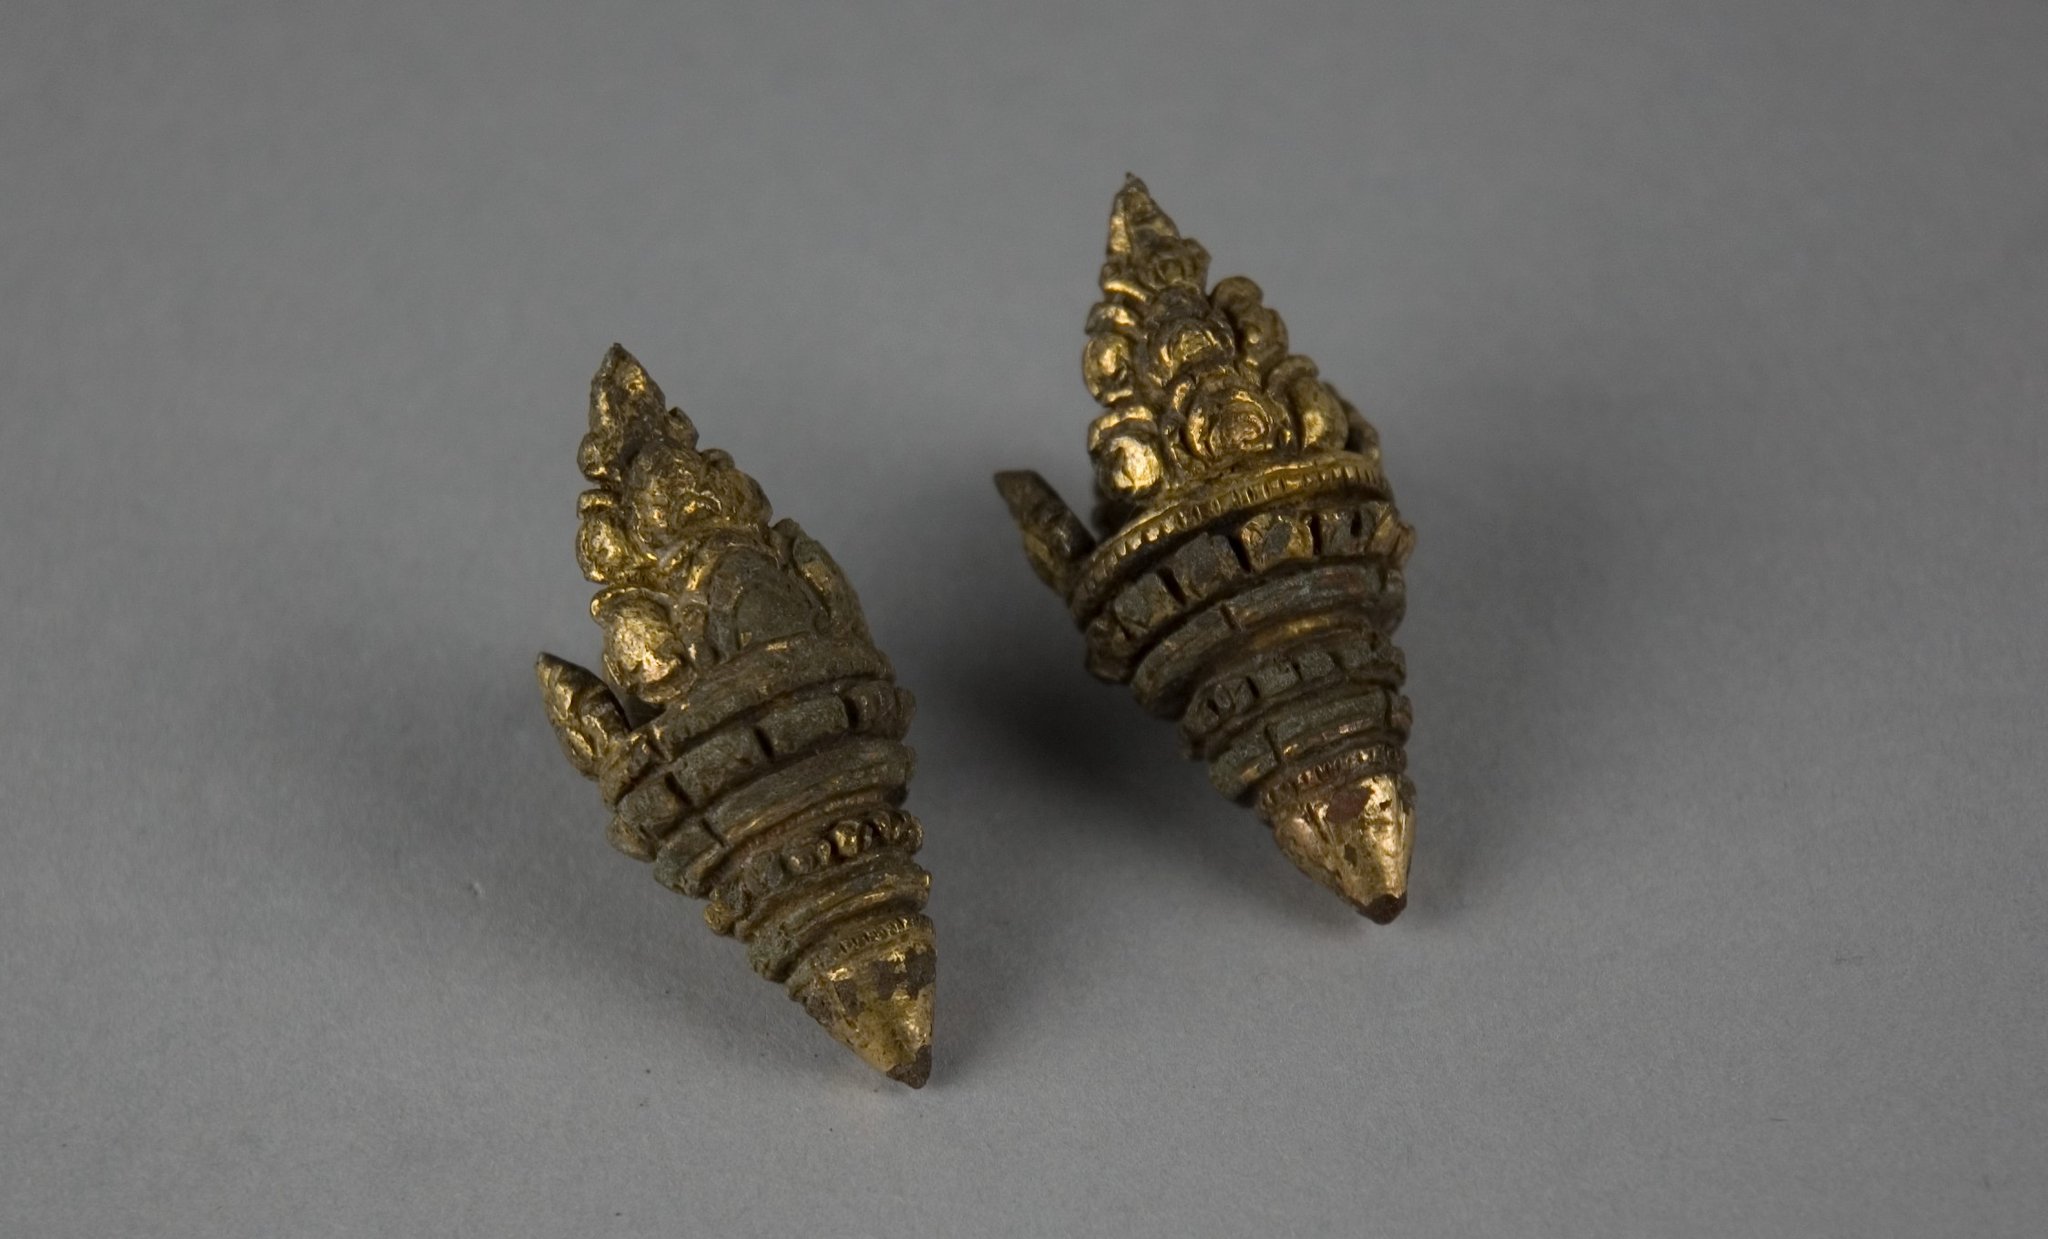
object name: ear clip one from a pair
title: Ear Clip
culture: cambodian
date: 1101-1200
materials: bronze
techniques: gilding